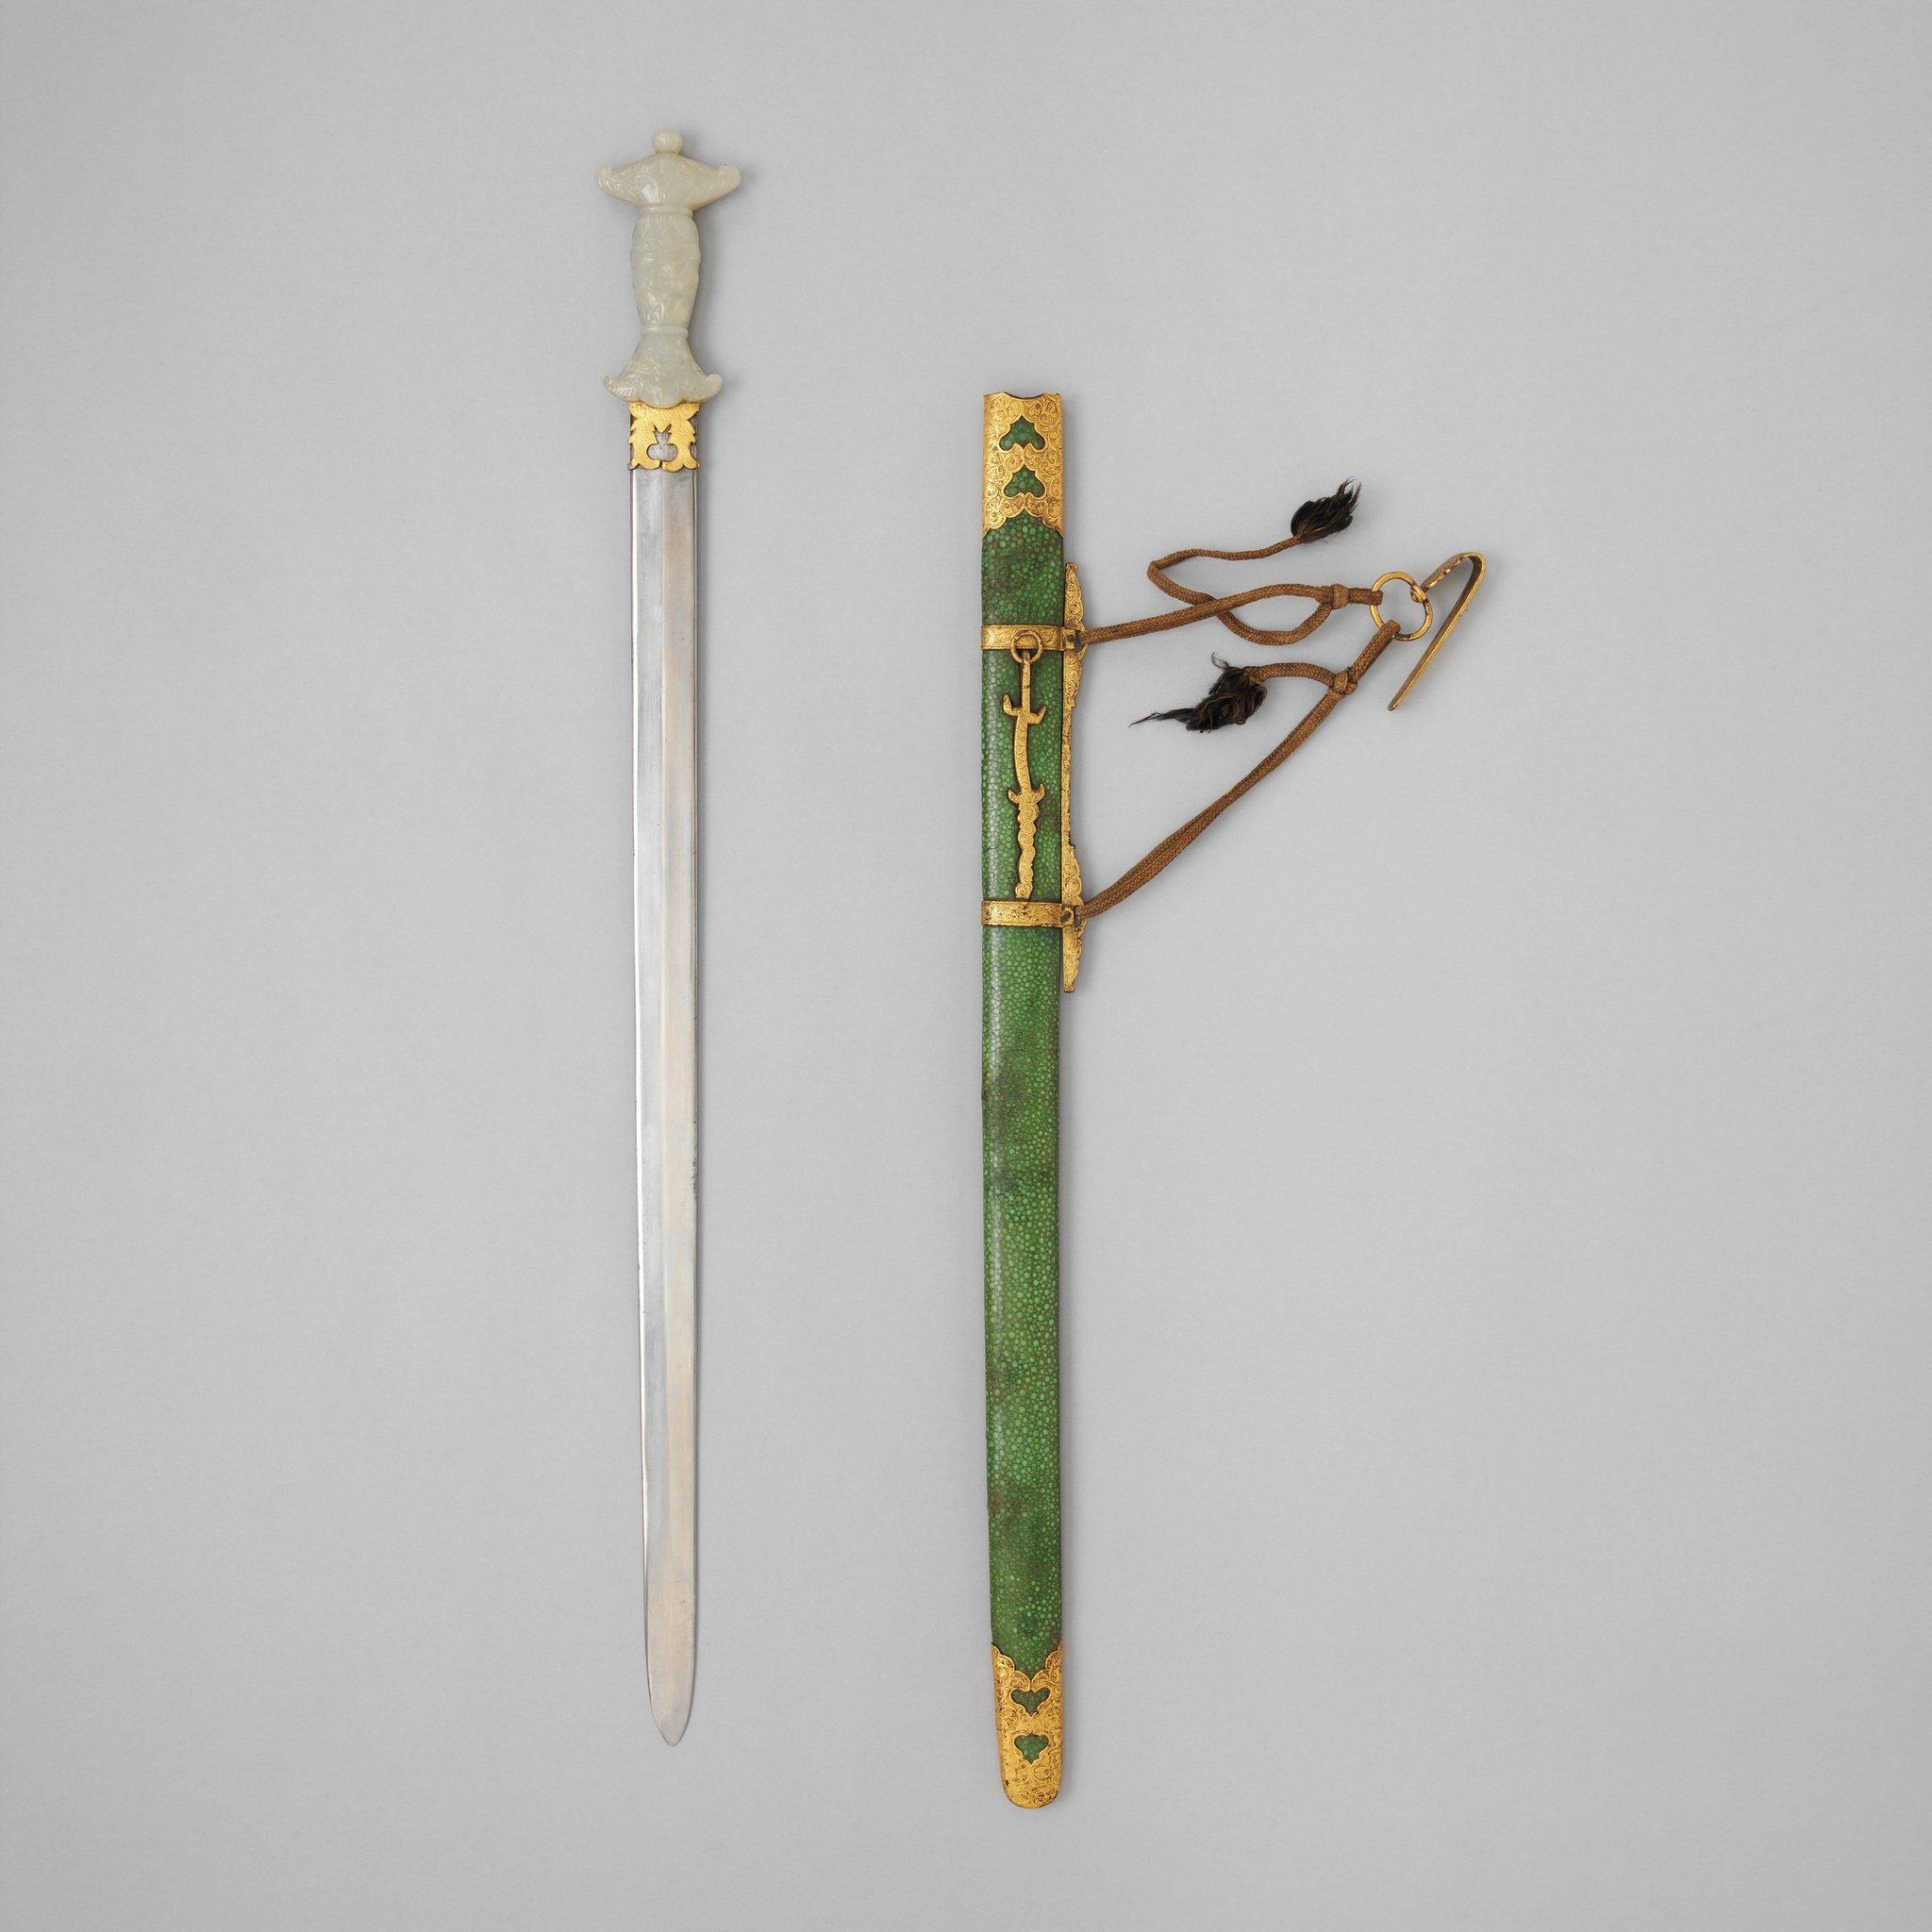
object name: sword with scabbard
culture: chinese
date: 1801-1900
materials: bronze, gold, jade, steel, textile, wood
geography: china